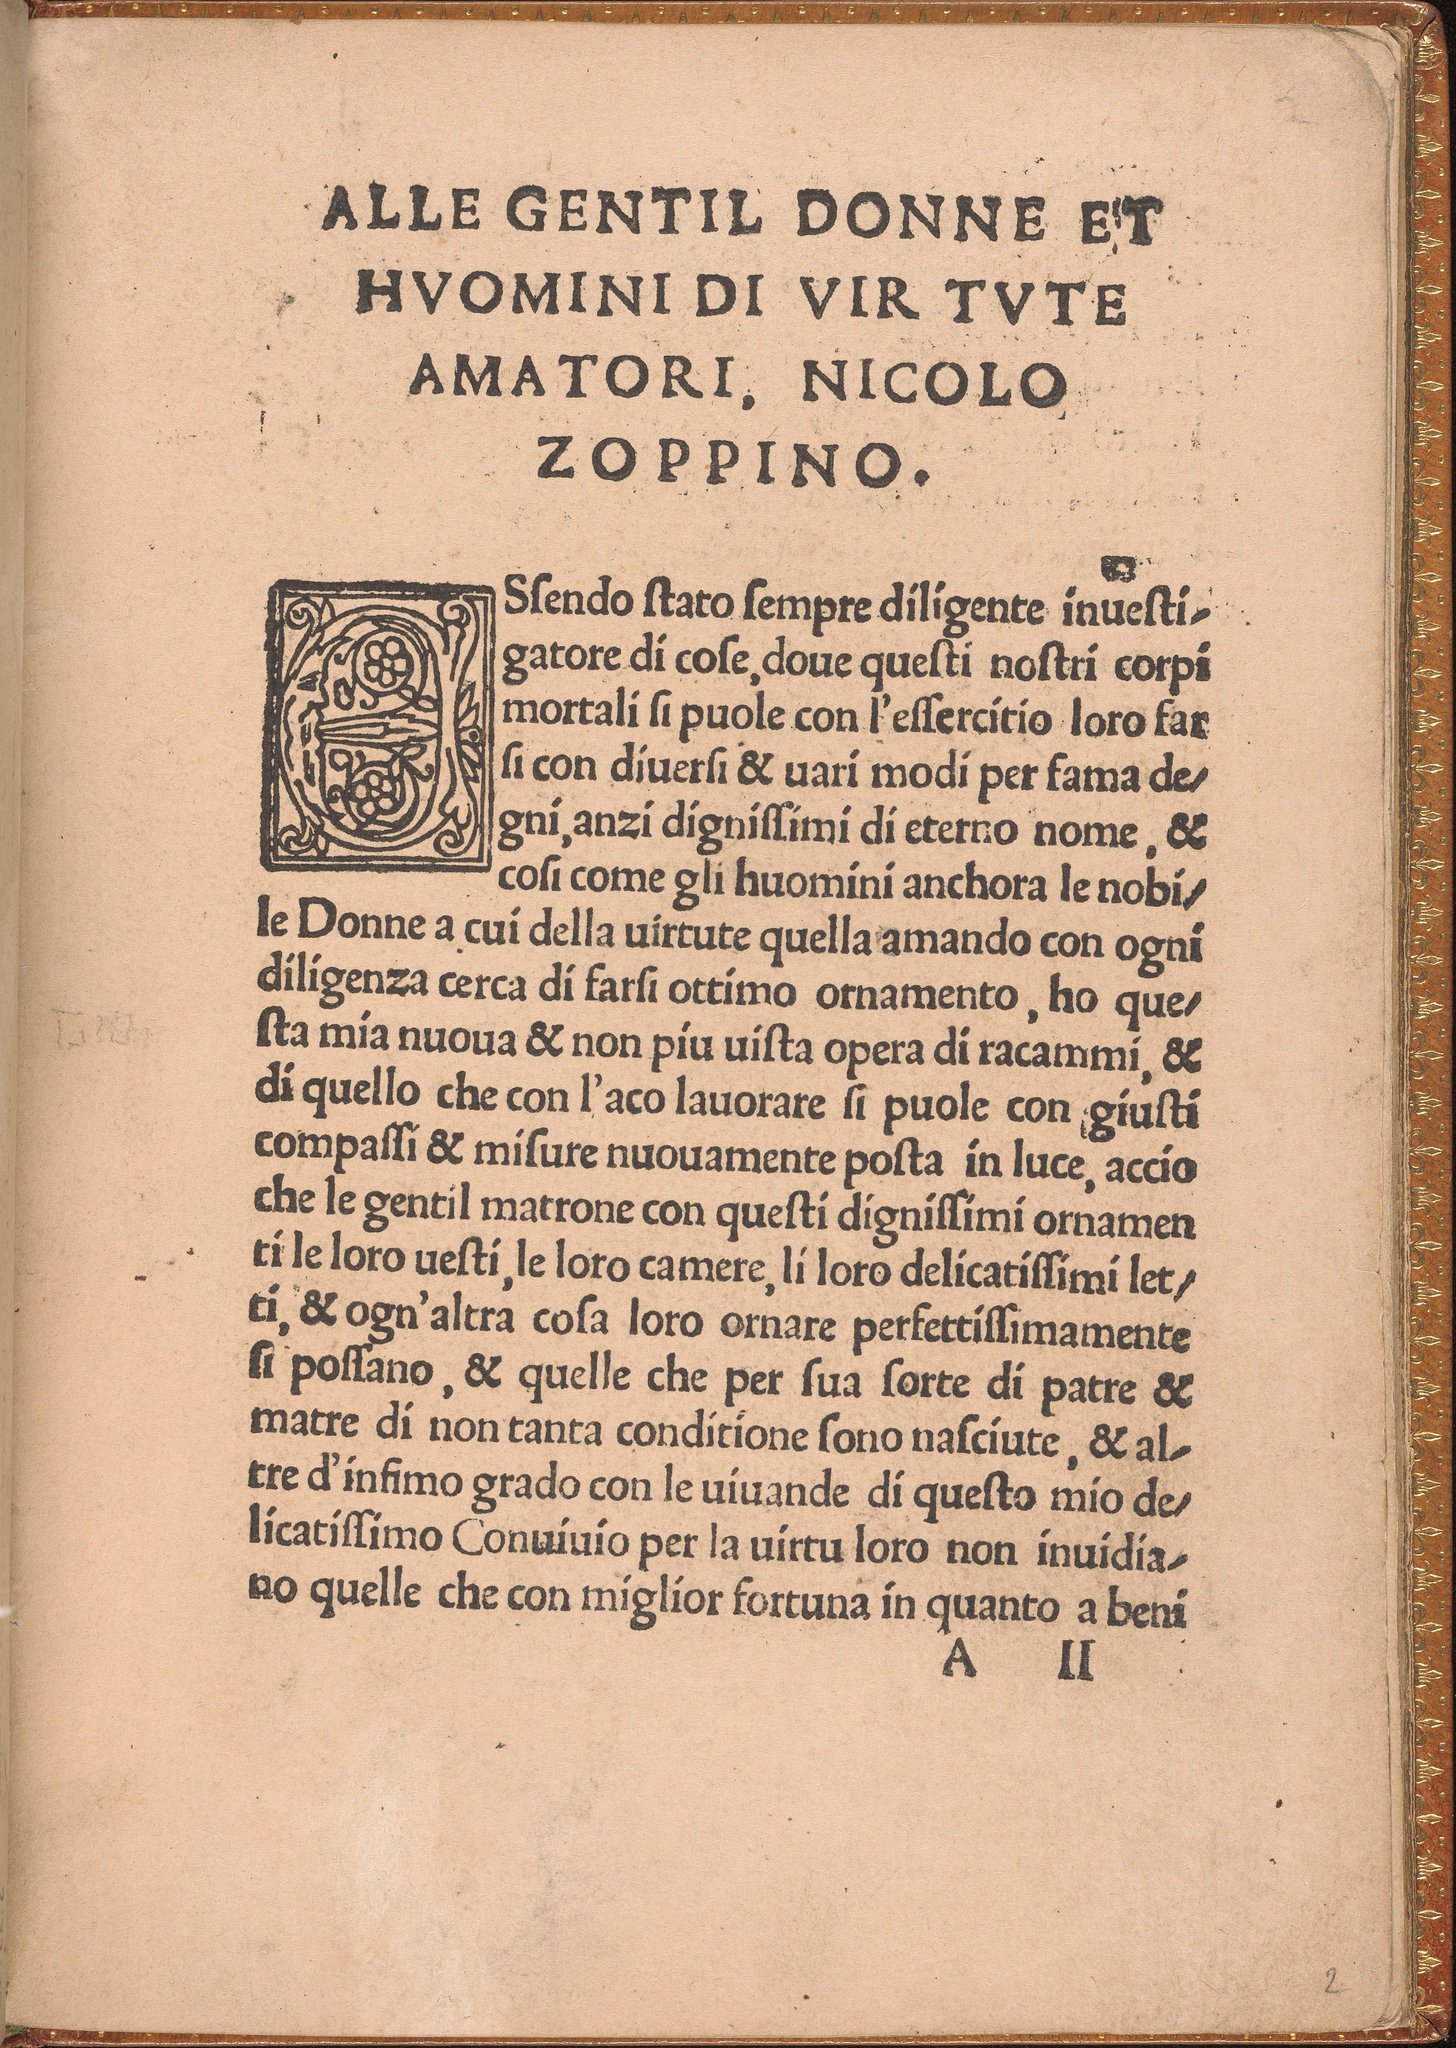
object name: book print ornament architecture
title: Convivio delle Belle Donne, page 2 (recto)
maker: nicolò zoppino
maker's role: publisher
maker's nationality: italian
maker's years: 1478-1544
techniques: woodcut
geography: italy